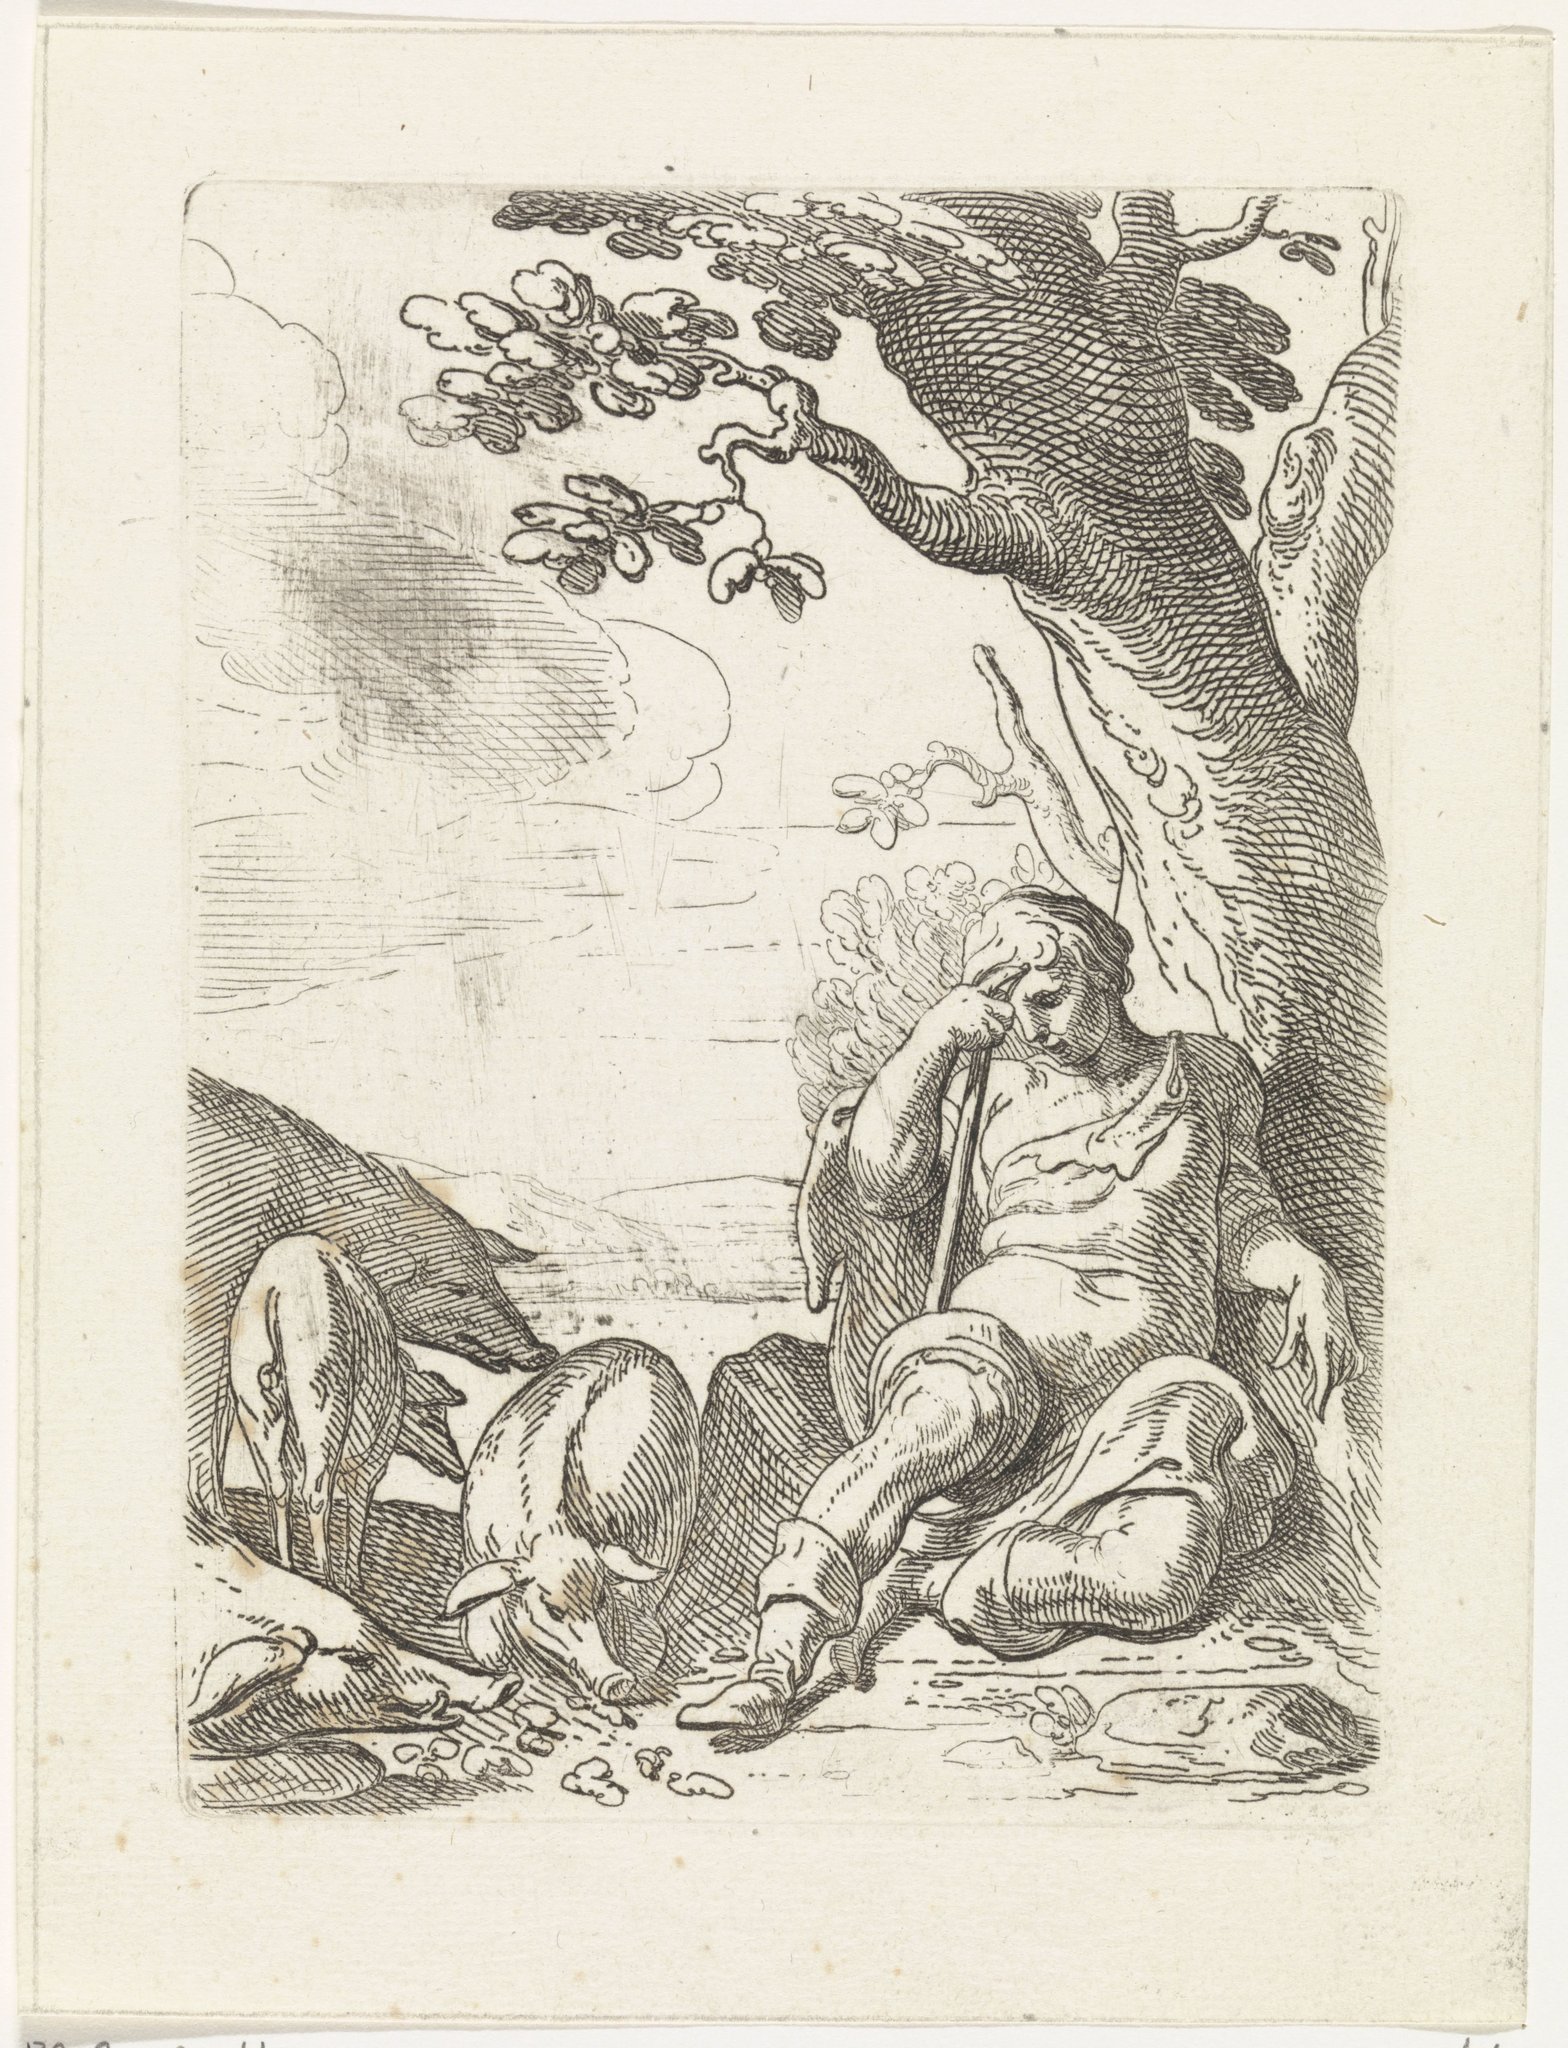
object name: print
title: Gelijkenis van de verloren zoon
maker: theodoor van thulden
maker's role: draughtsman, painter, print maker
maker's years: 1606-1669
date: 1616-1669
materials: paper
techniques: engraving, etching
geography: antwerp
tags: the prodigal son tends the swine and eats from their trough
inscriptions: collector's mark: Lugt 240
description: De verloren zoon als varkenshoeder zittend onder een boom.